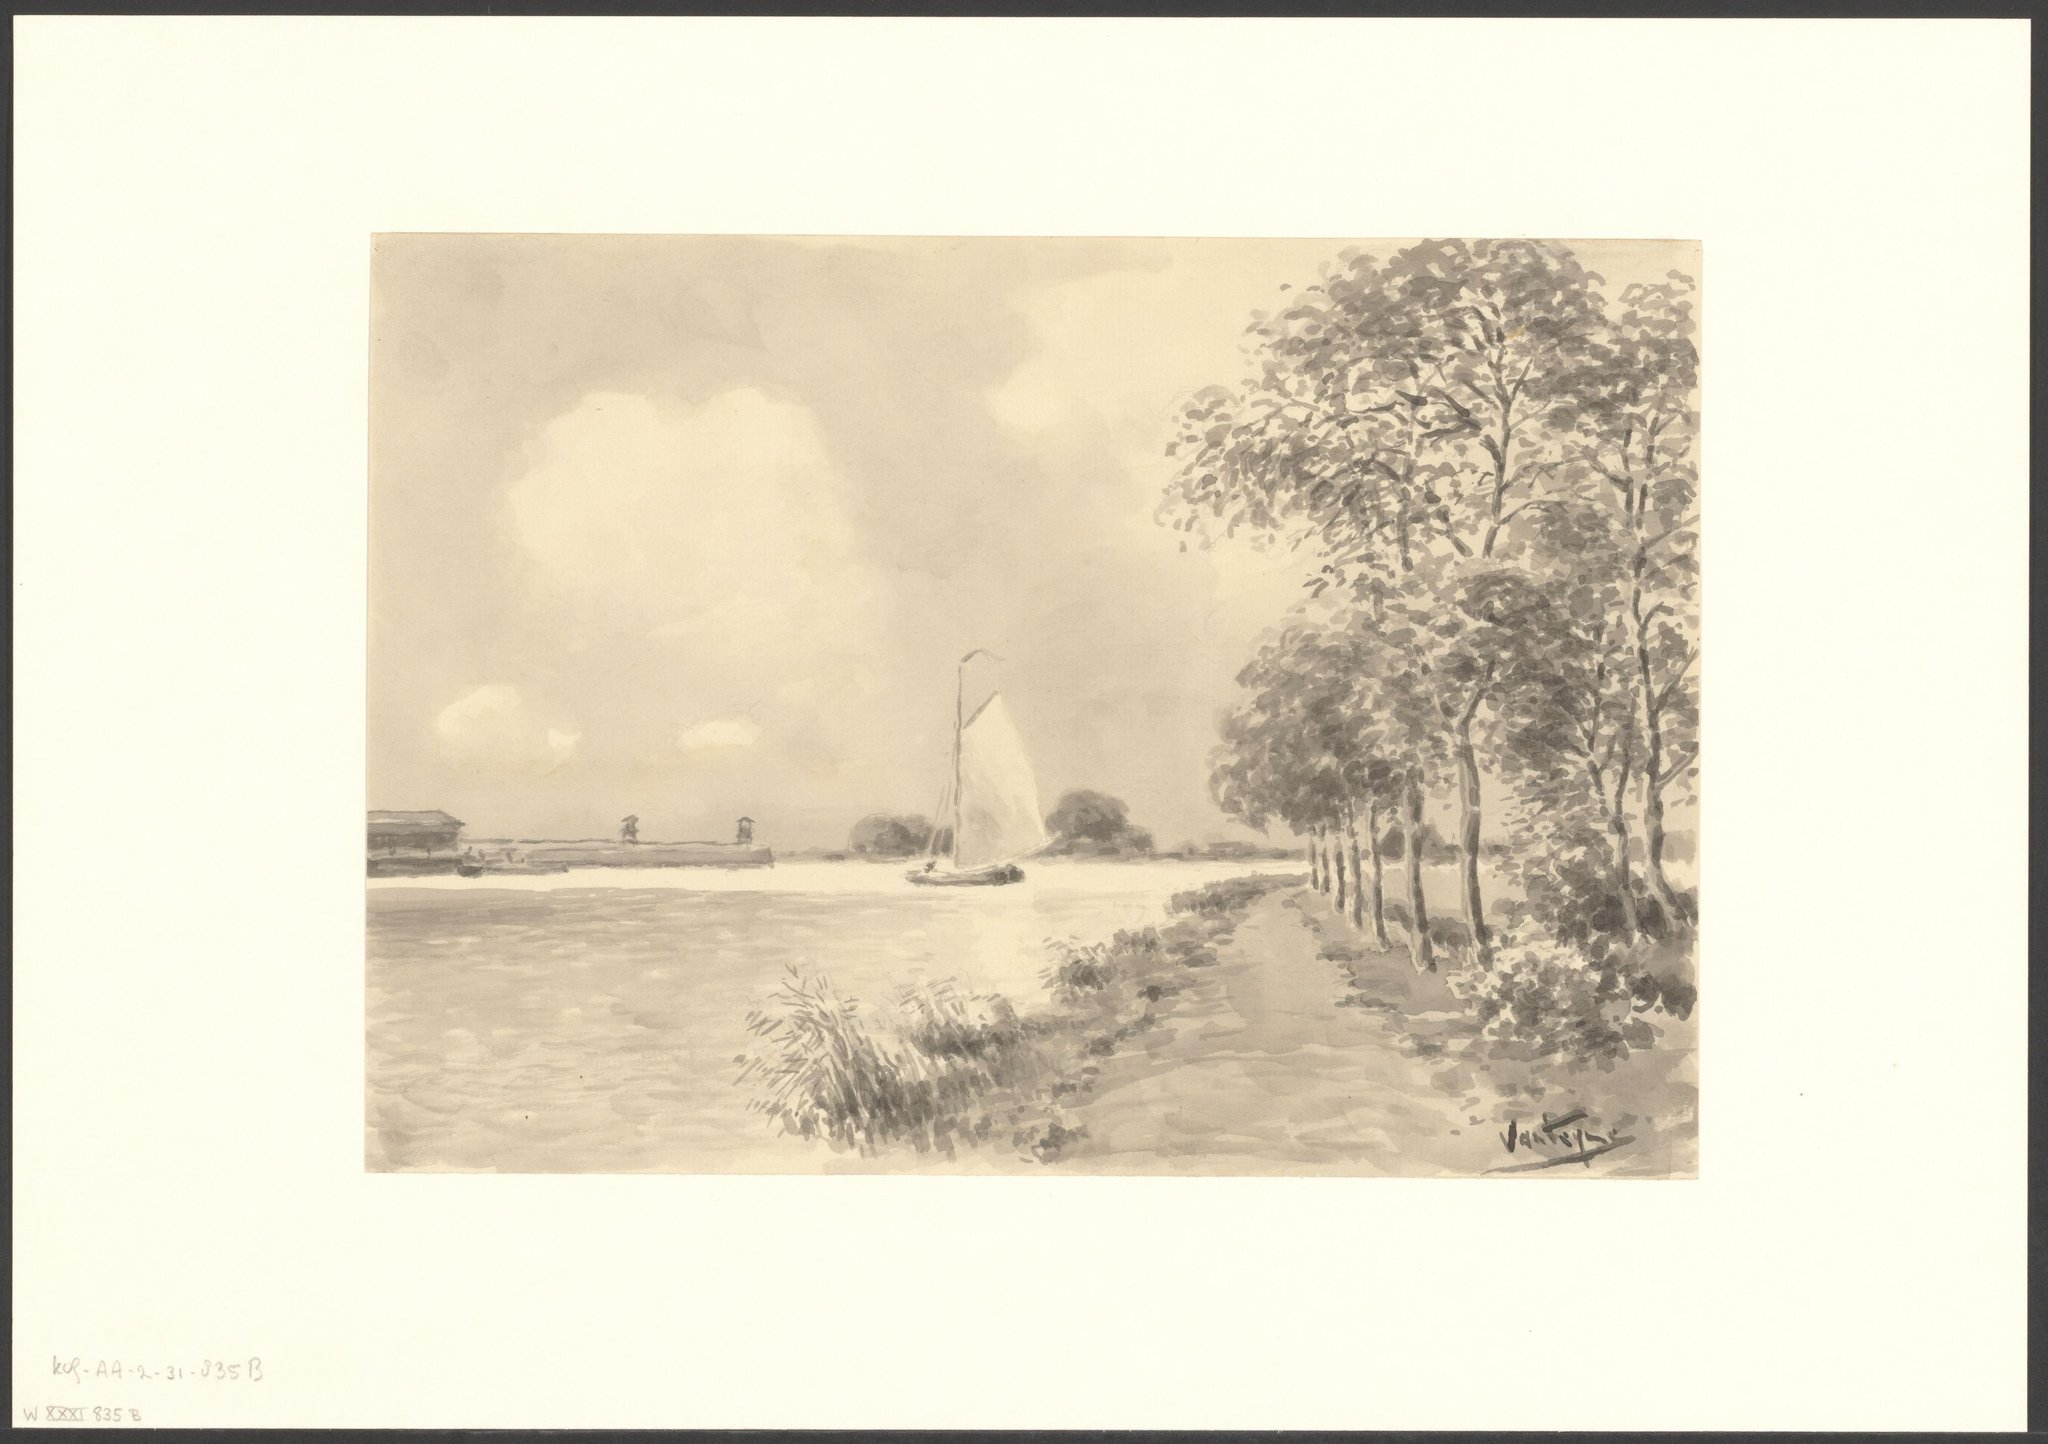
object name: drawing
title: Gezicht op het Jaagpad aan de Schinkel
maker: anthonie van teijn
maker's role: draughtsman, painter, print maker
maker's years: 1863-1943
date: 1910-1927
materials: ink, paper, pencil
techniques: brush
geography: amsterdam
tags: sailing-ship, sailing-boat, city-view in general; 'veduta', river, road, path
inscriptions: collector's mark: Lugt 800a, signature: ‘VanTeyne’, inscription: ‘Het Jaagpad langs (...) Oct 1927. / vanEck’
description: Tekening binnen de Atlas Van Eck ingedeeld op wijknummer 31.